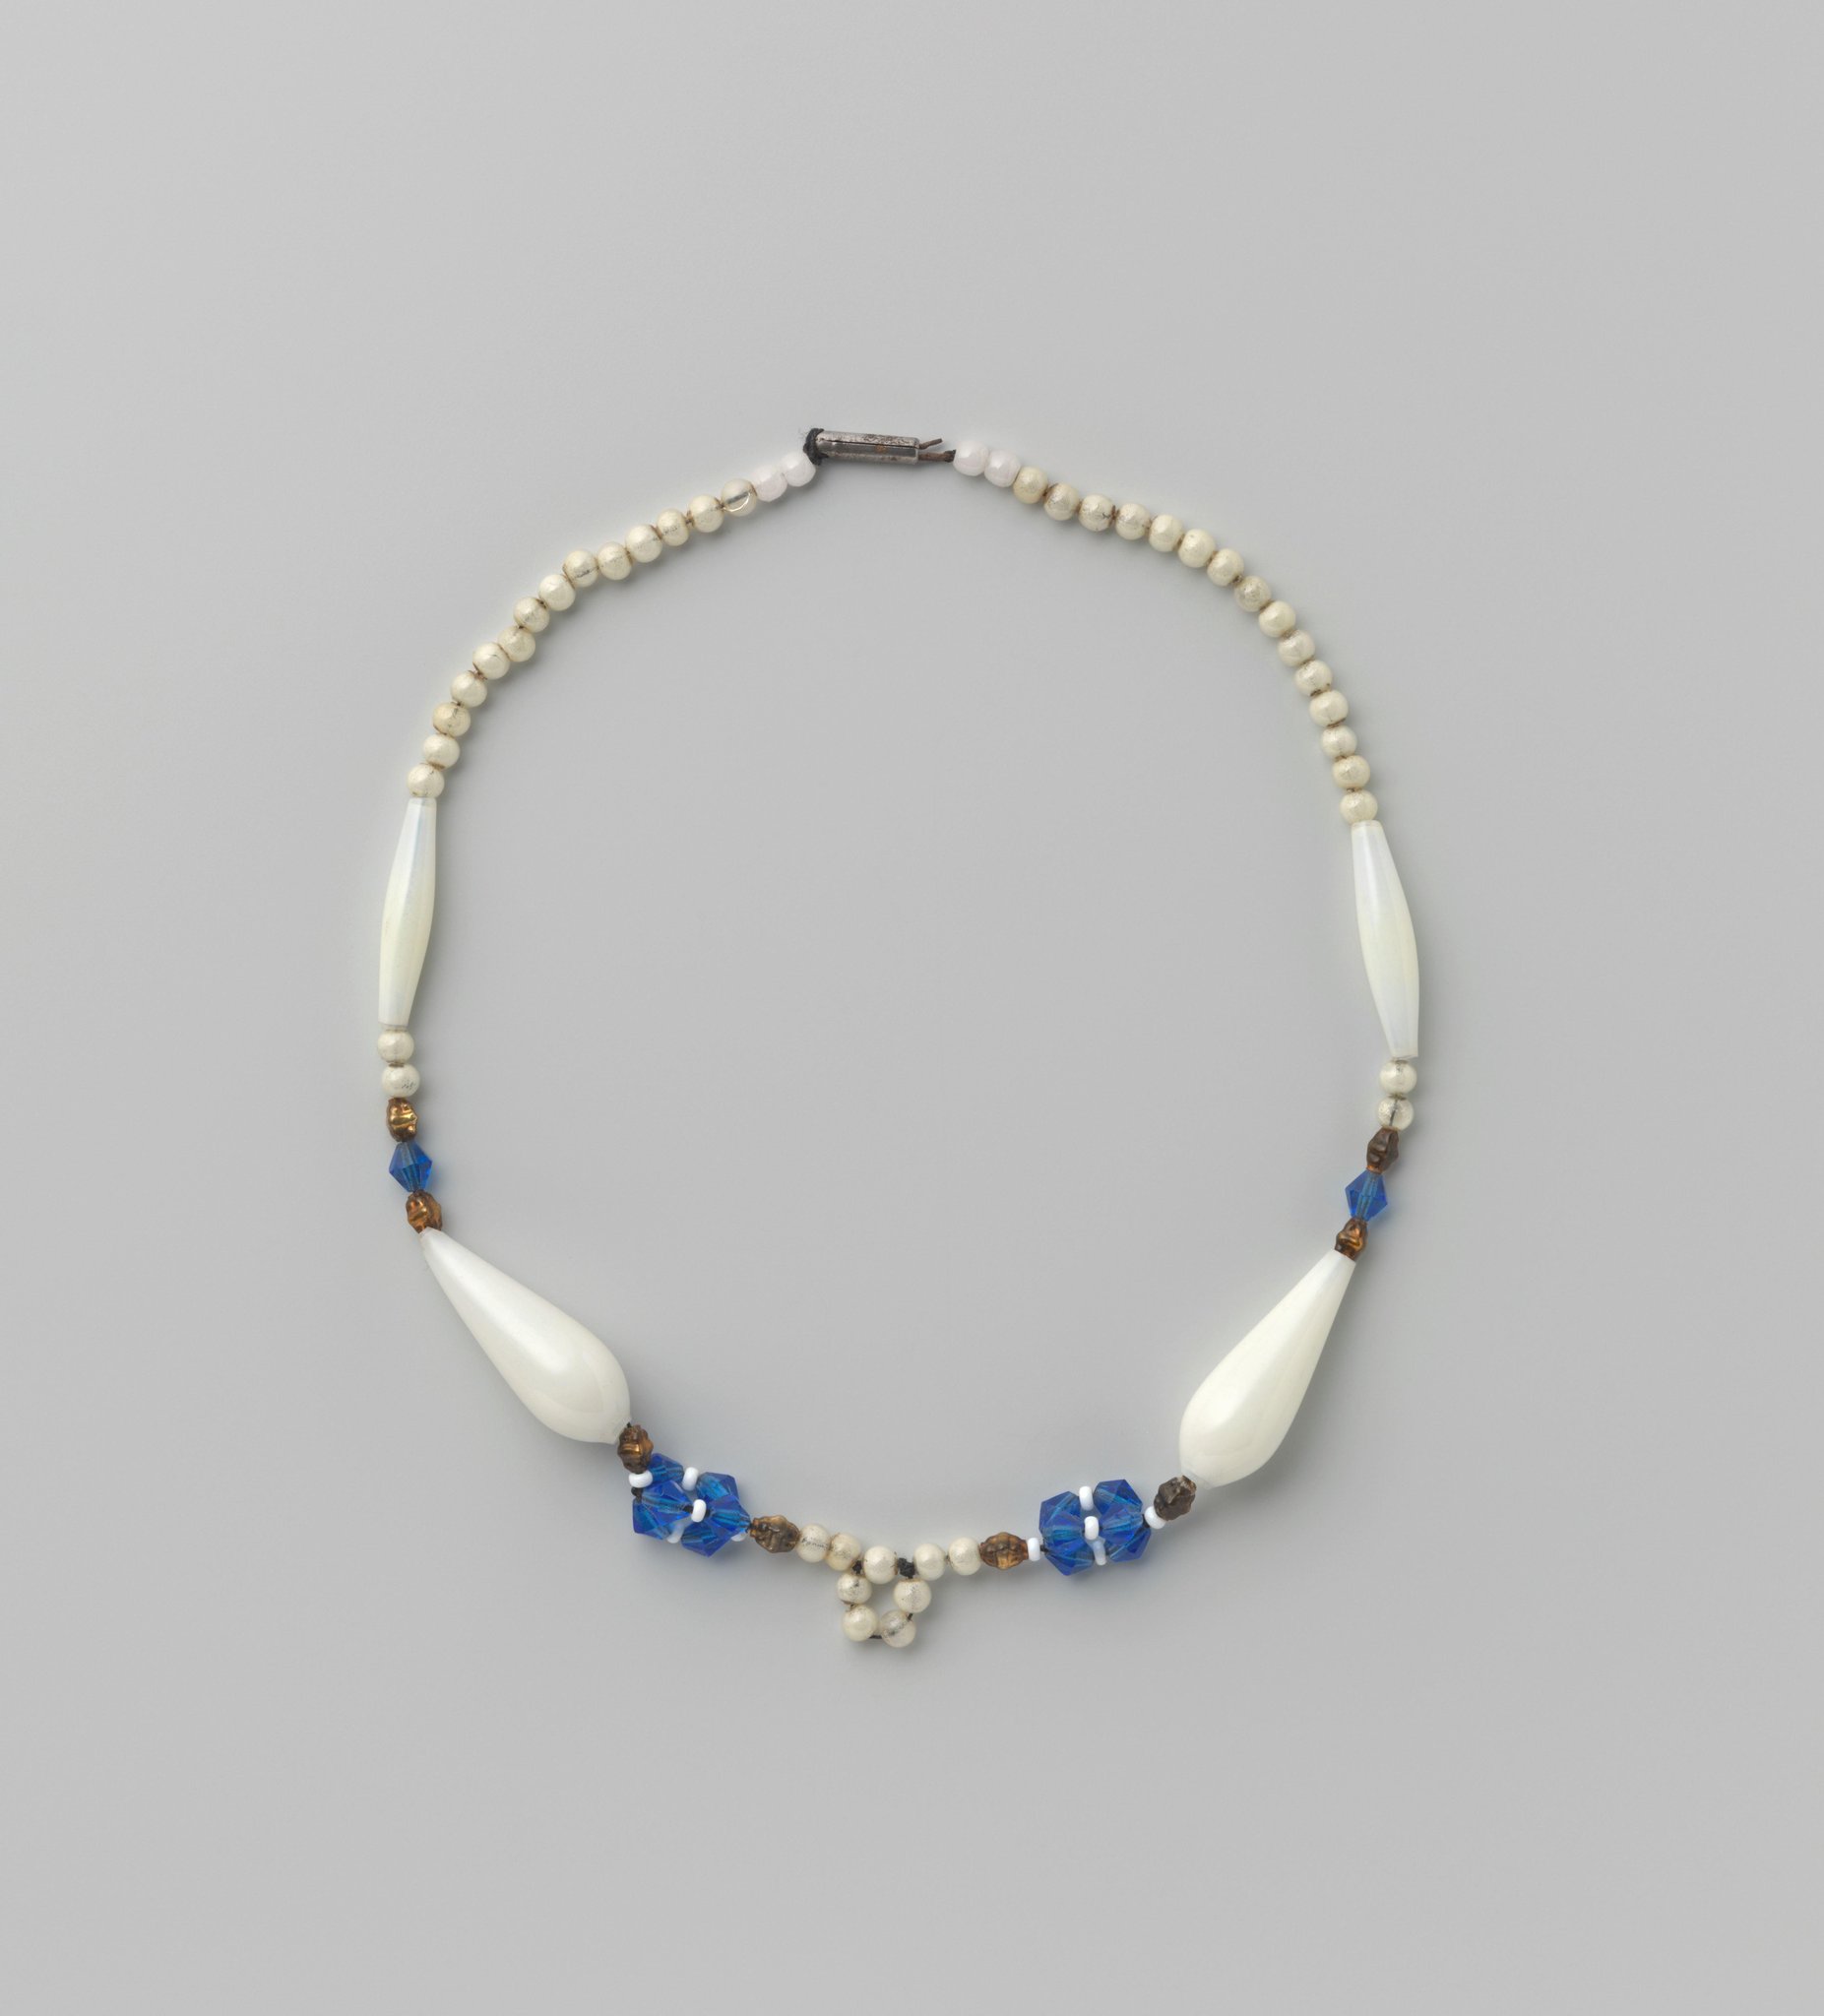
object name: necklace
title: Collier van fluoriserend glas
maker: Anonymous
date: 1940-1945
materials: glass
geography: europe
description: Collier van fluoriserend glas dat oplicht in het donker voorzien van een smalle baksluiting.